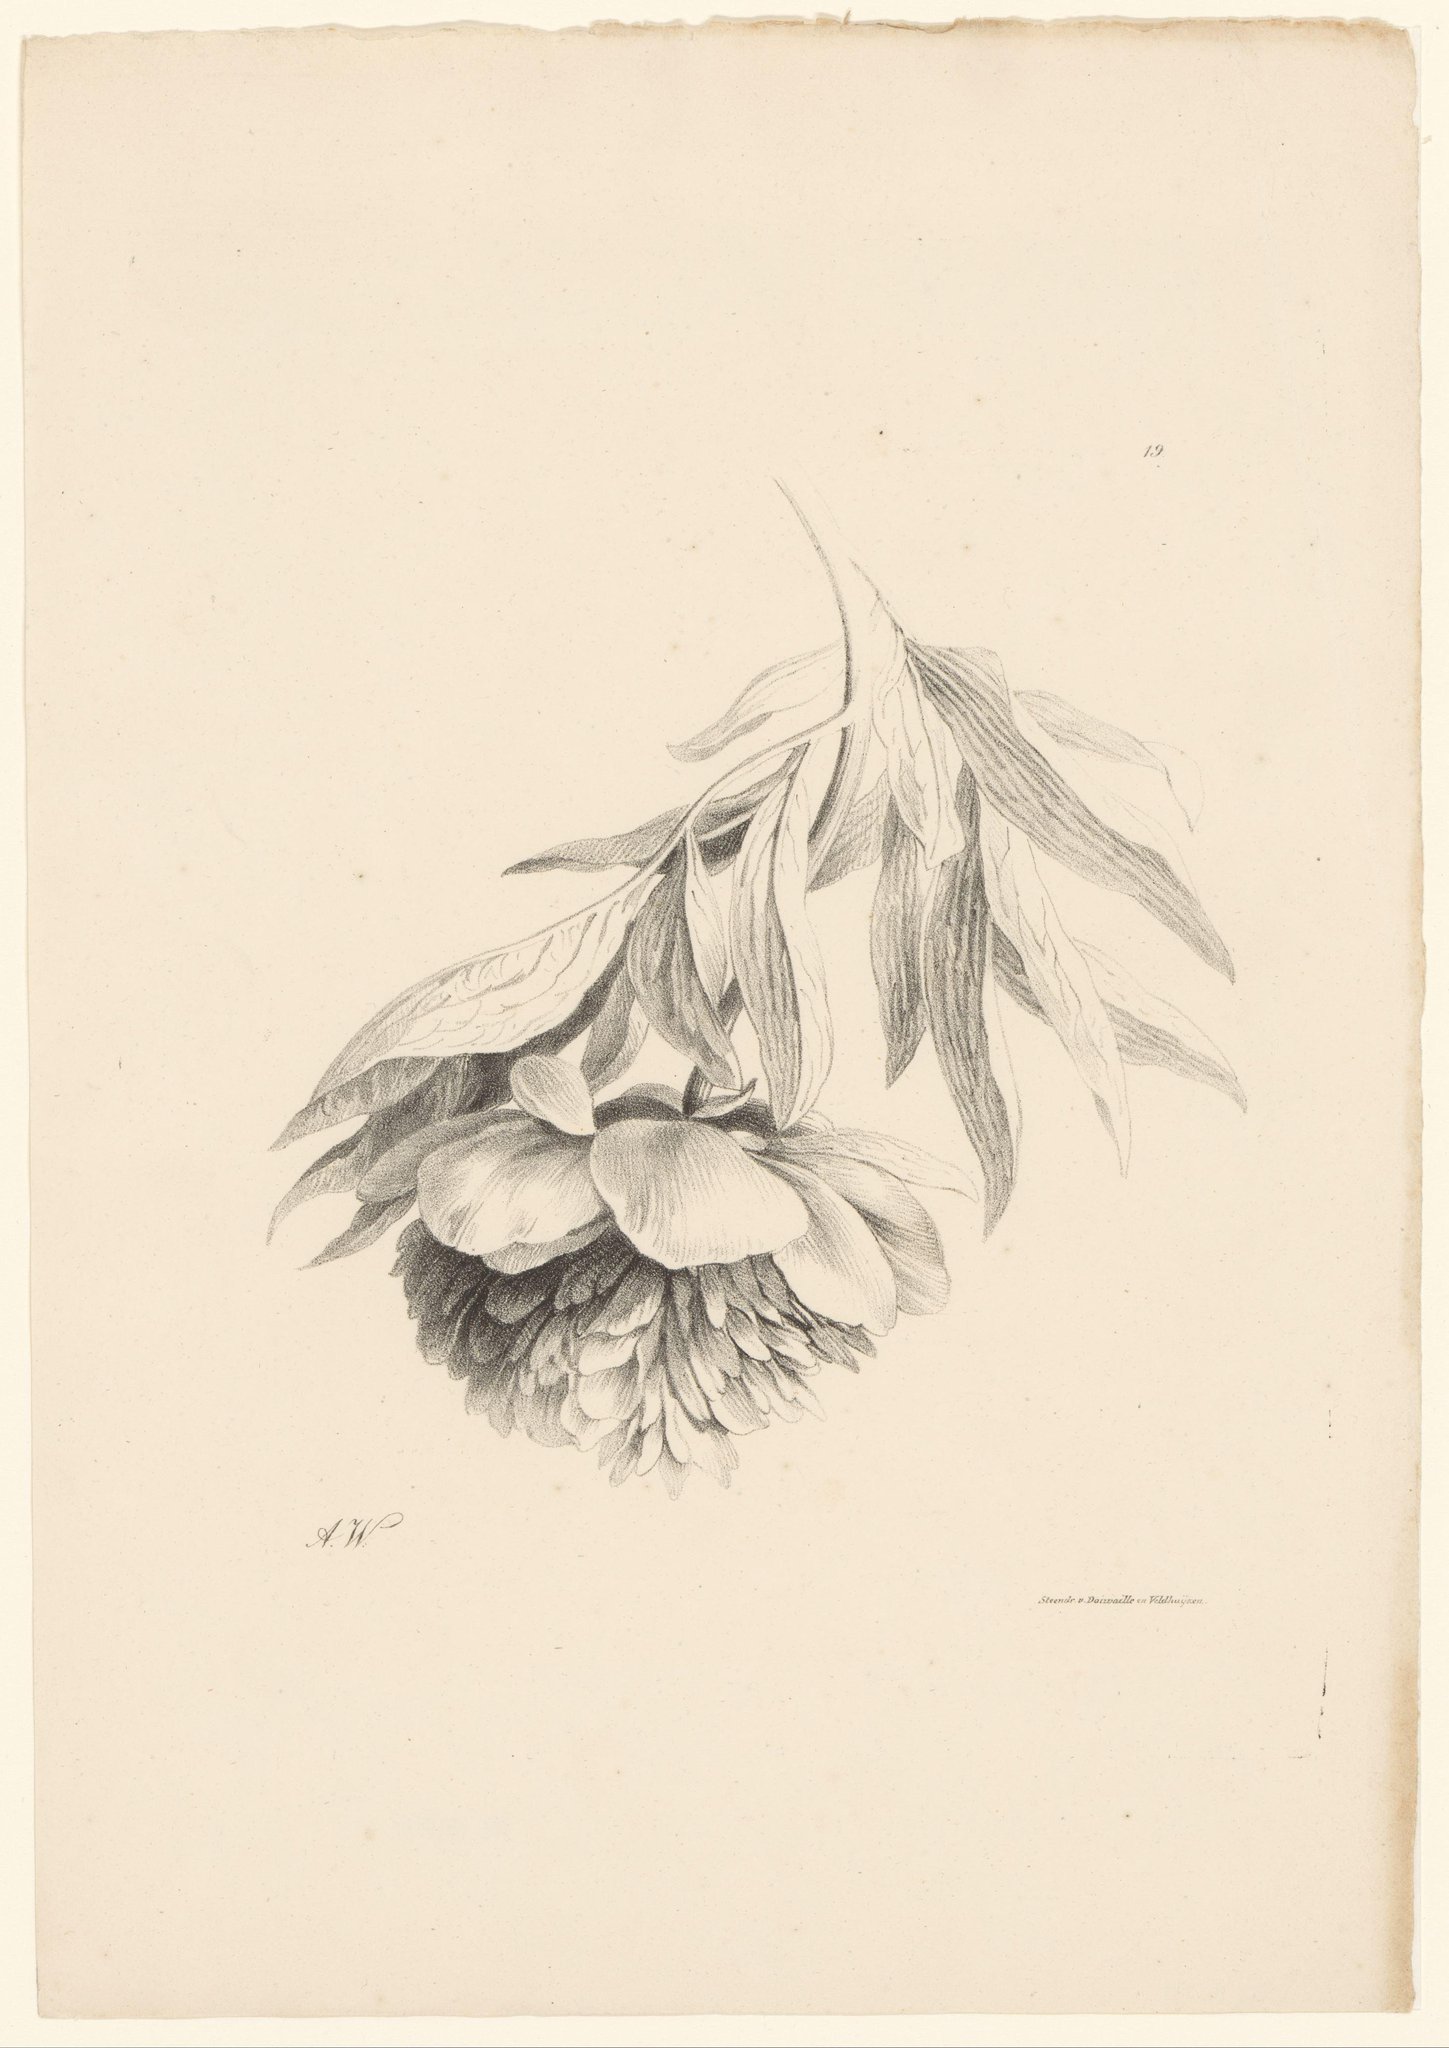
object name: print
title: Bloem naar onderen gekeerd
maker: anton weiss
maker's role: draughtsman, print maker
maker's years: 1801-1851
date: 1831-1832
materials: paper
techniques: lithograph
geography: amsterdam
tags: flowers